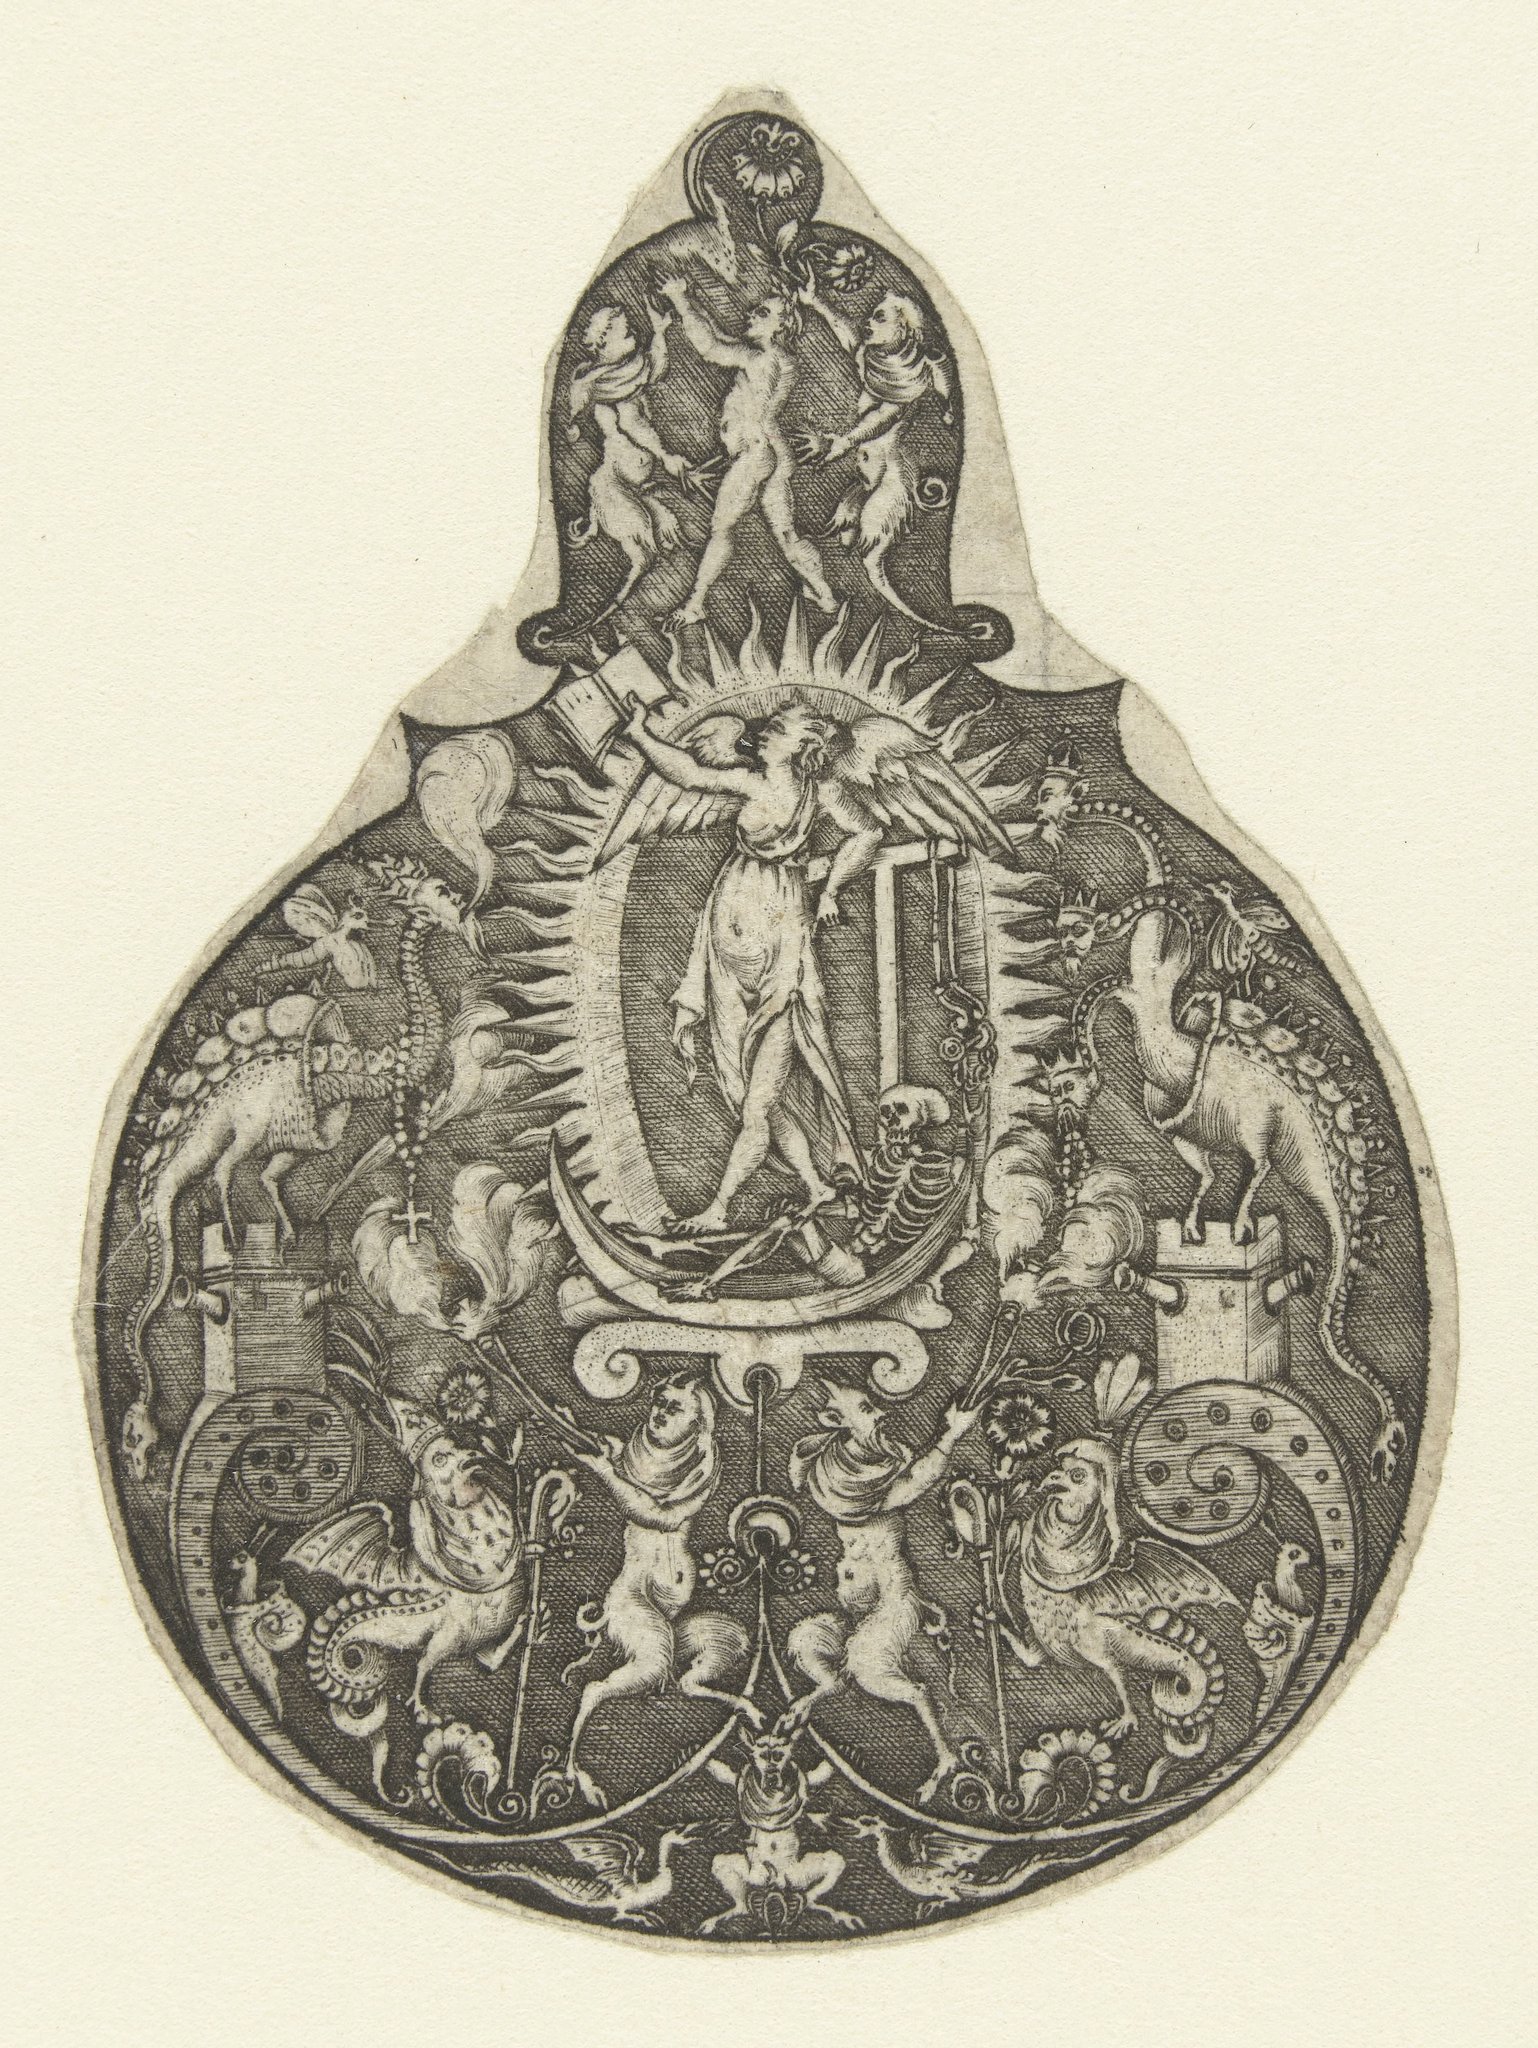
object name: ornament print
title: Hanger met in het midden een gevleugelde vrouw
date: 1528-1583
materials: paper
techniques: engraving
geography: france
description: De vrouw houdt een boek in haar hand en wordt omgeven door stralen.